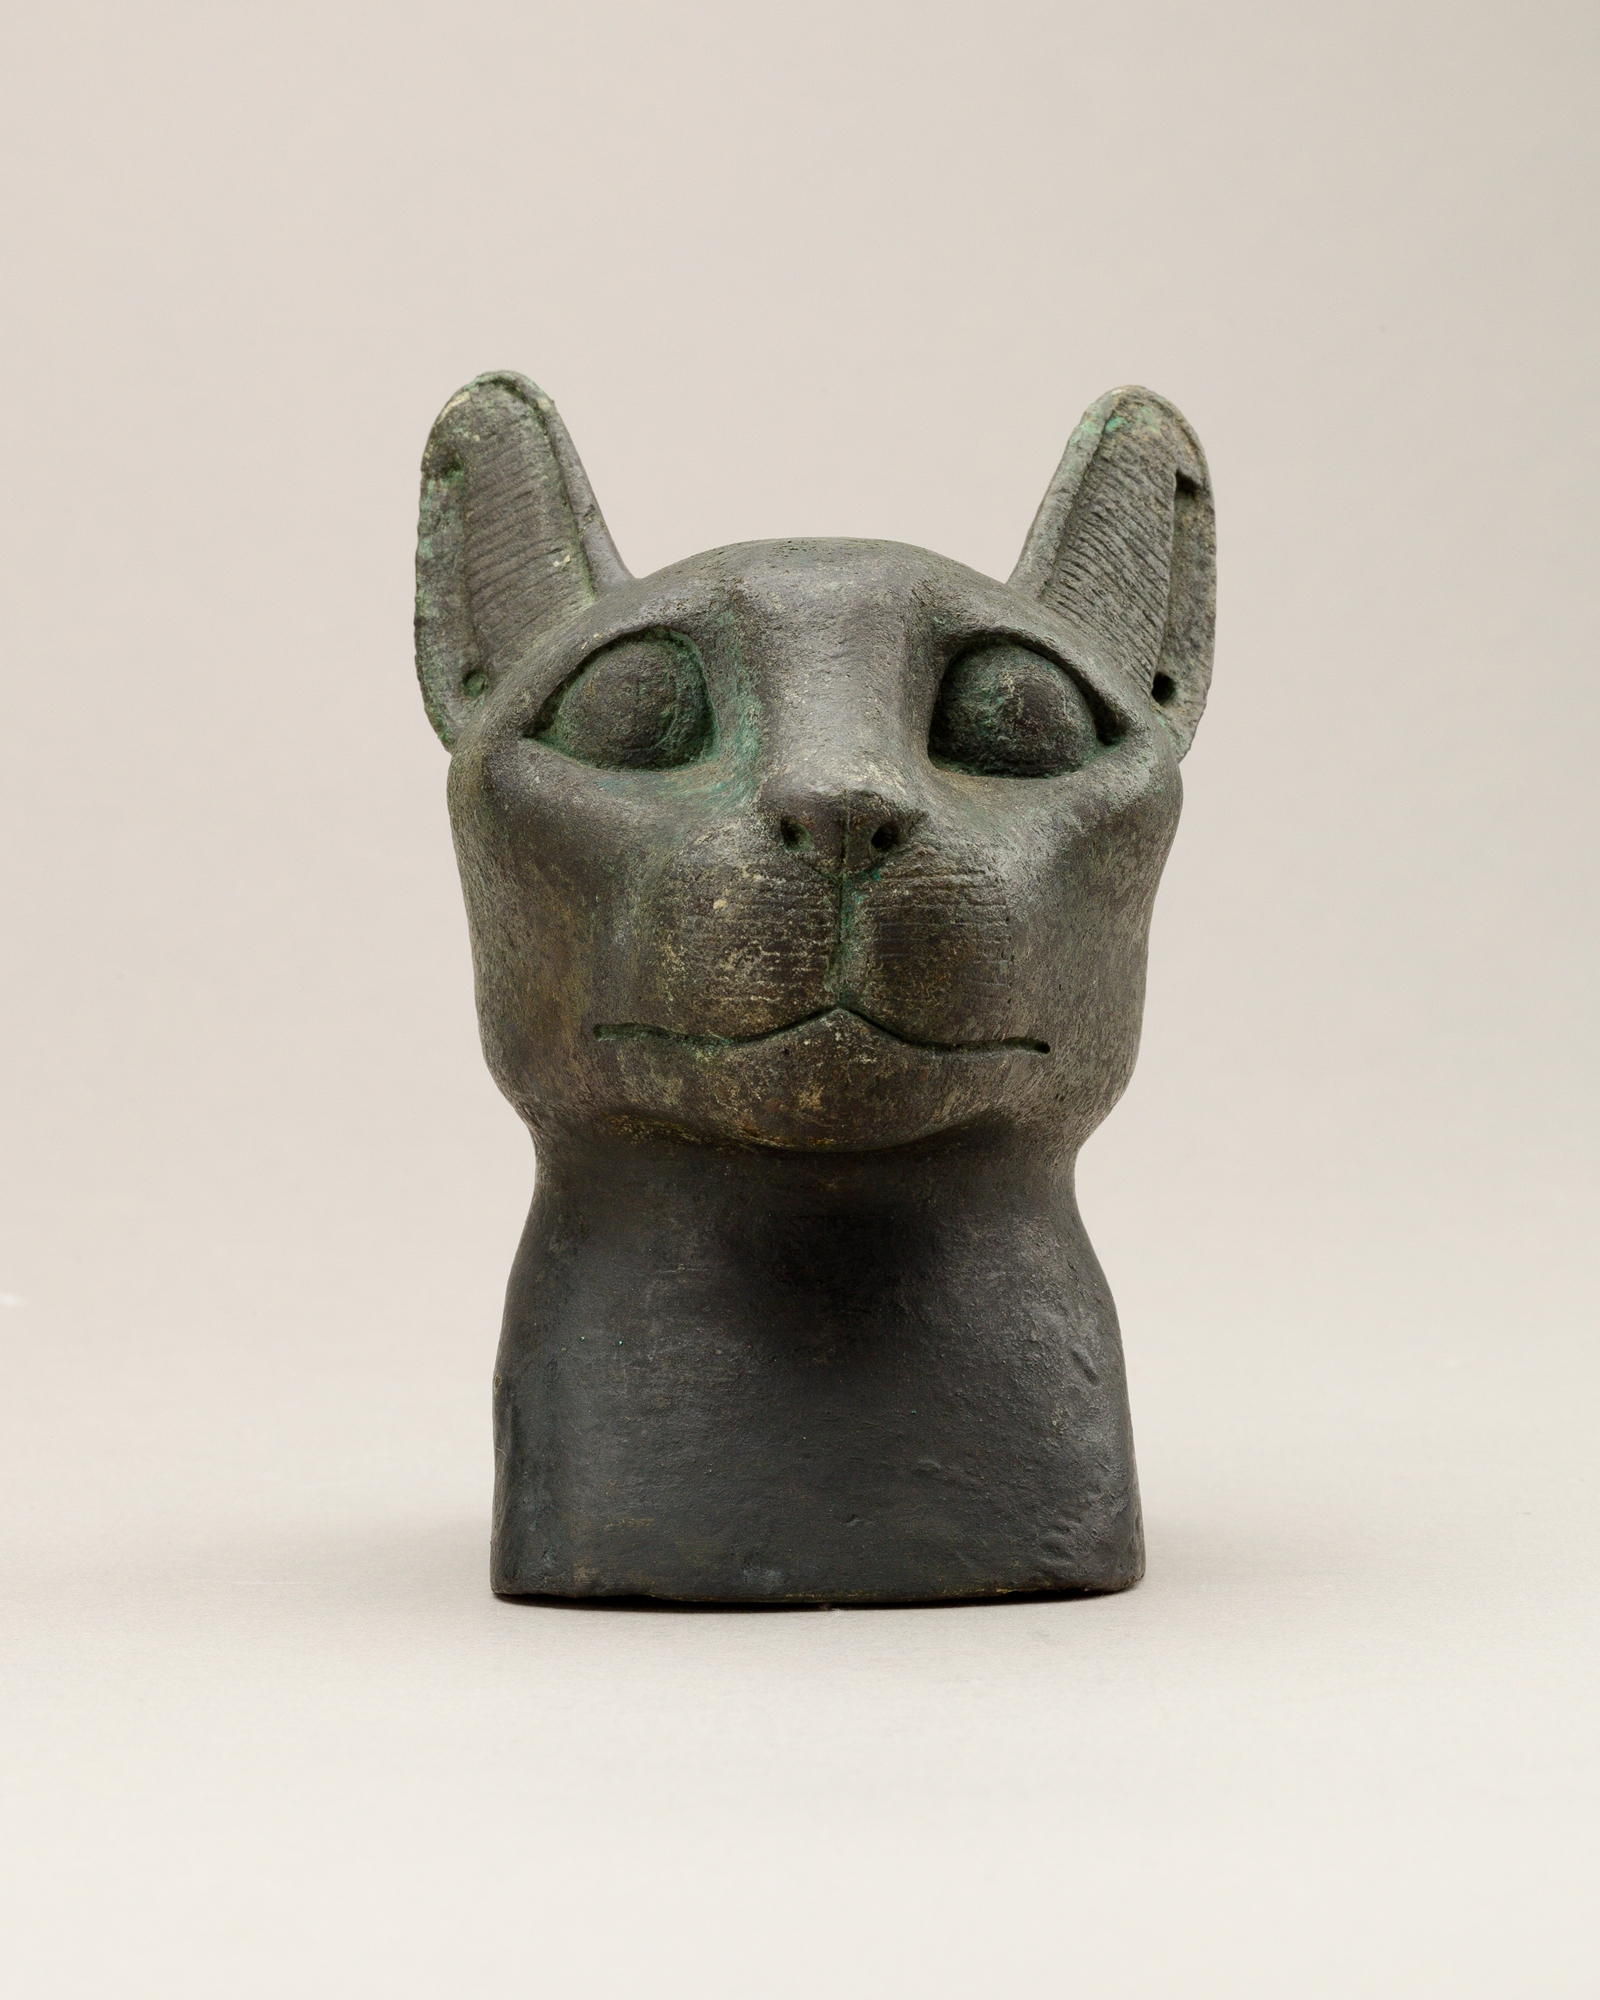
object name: head, cat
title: Head of a cat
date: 664-630 BCE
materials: metal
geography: egypt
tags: cats,goddess